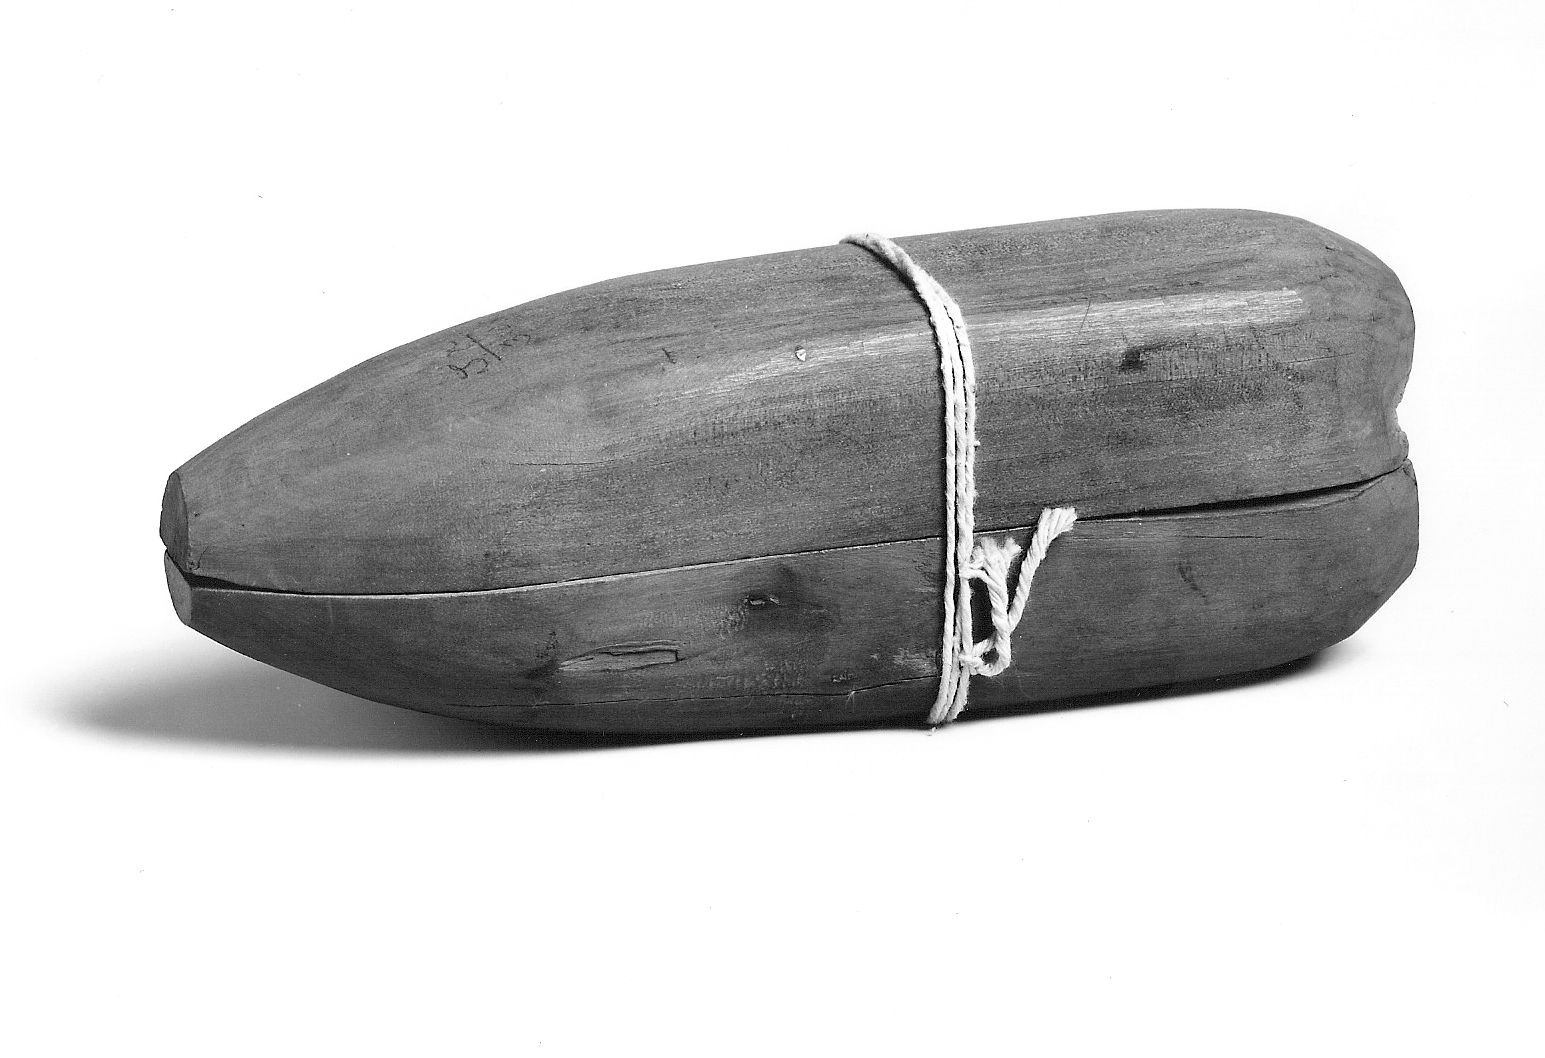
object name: clapper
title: Clappers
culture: malagasy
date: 1867-1900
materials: wood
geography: madagascar